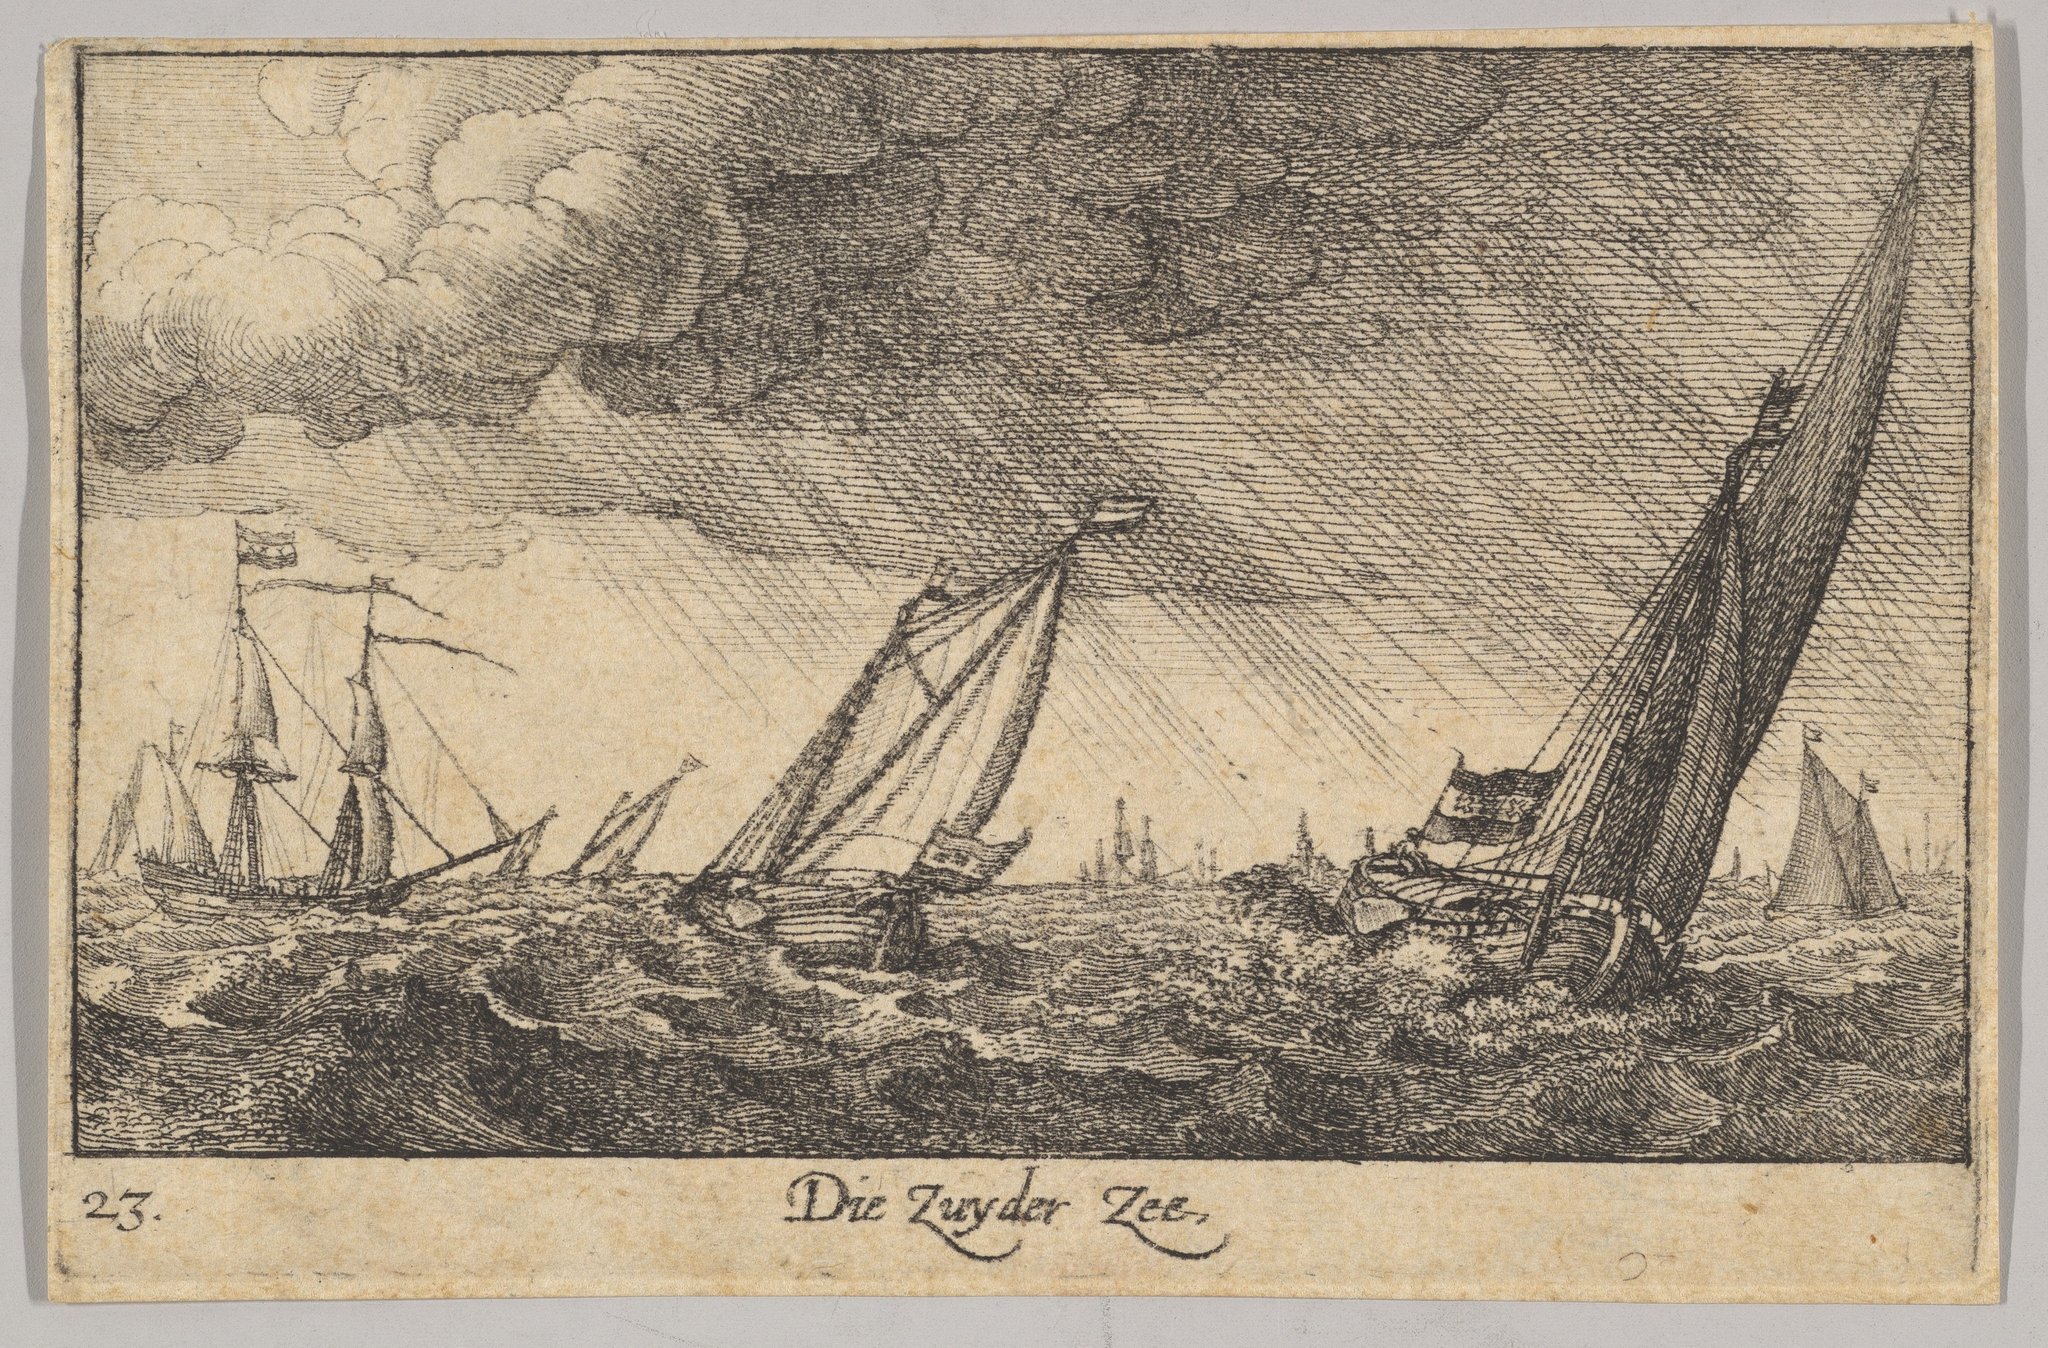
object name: print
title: Zuyder Zee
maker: wenceslaus hollar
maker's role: artist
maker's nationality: bohemian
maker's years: 1607-1677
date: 1635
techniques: etching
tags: storms,ships